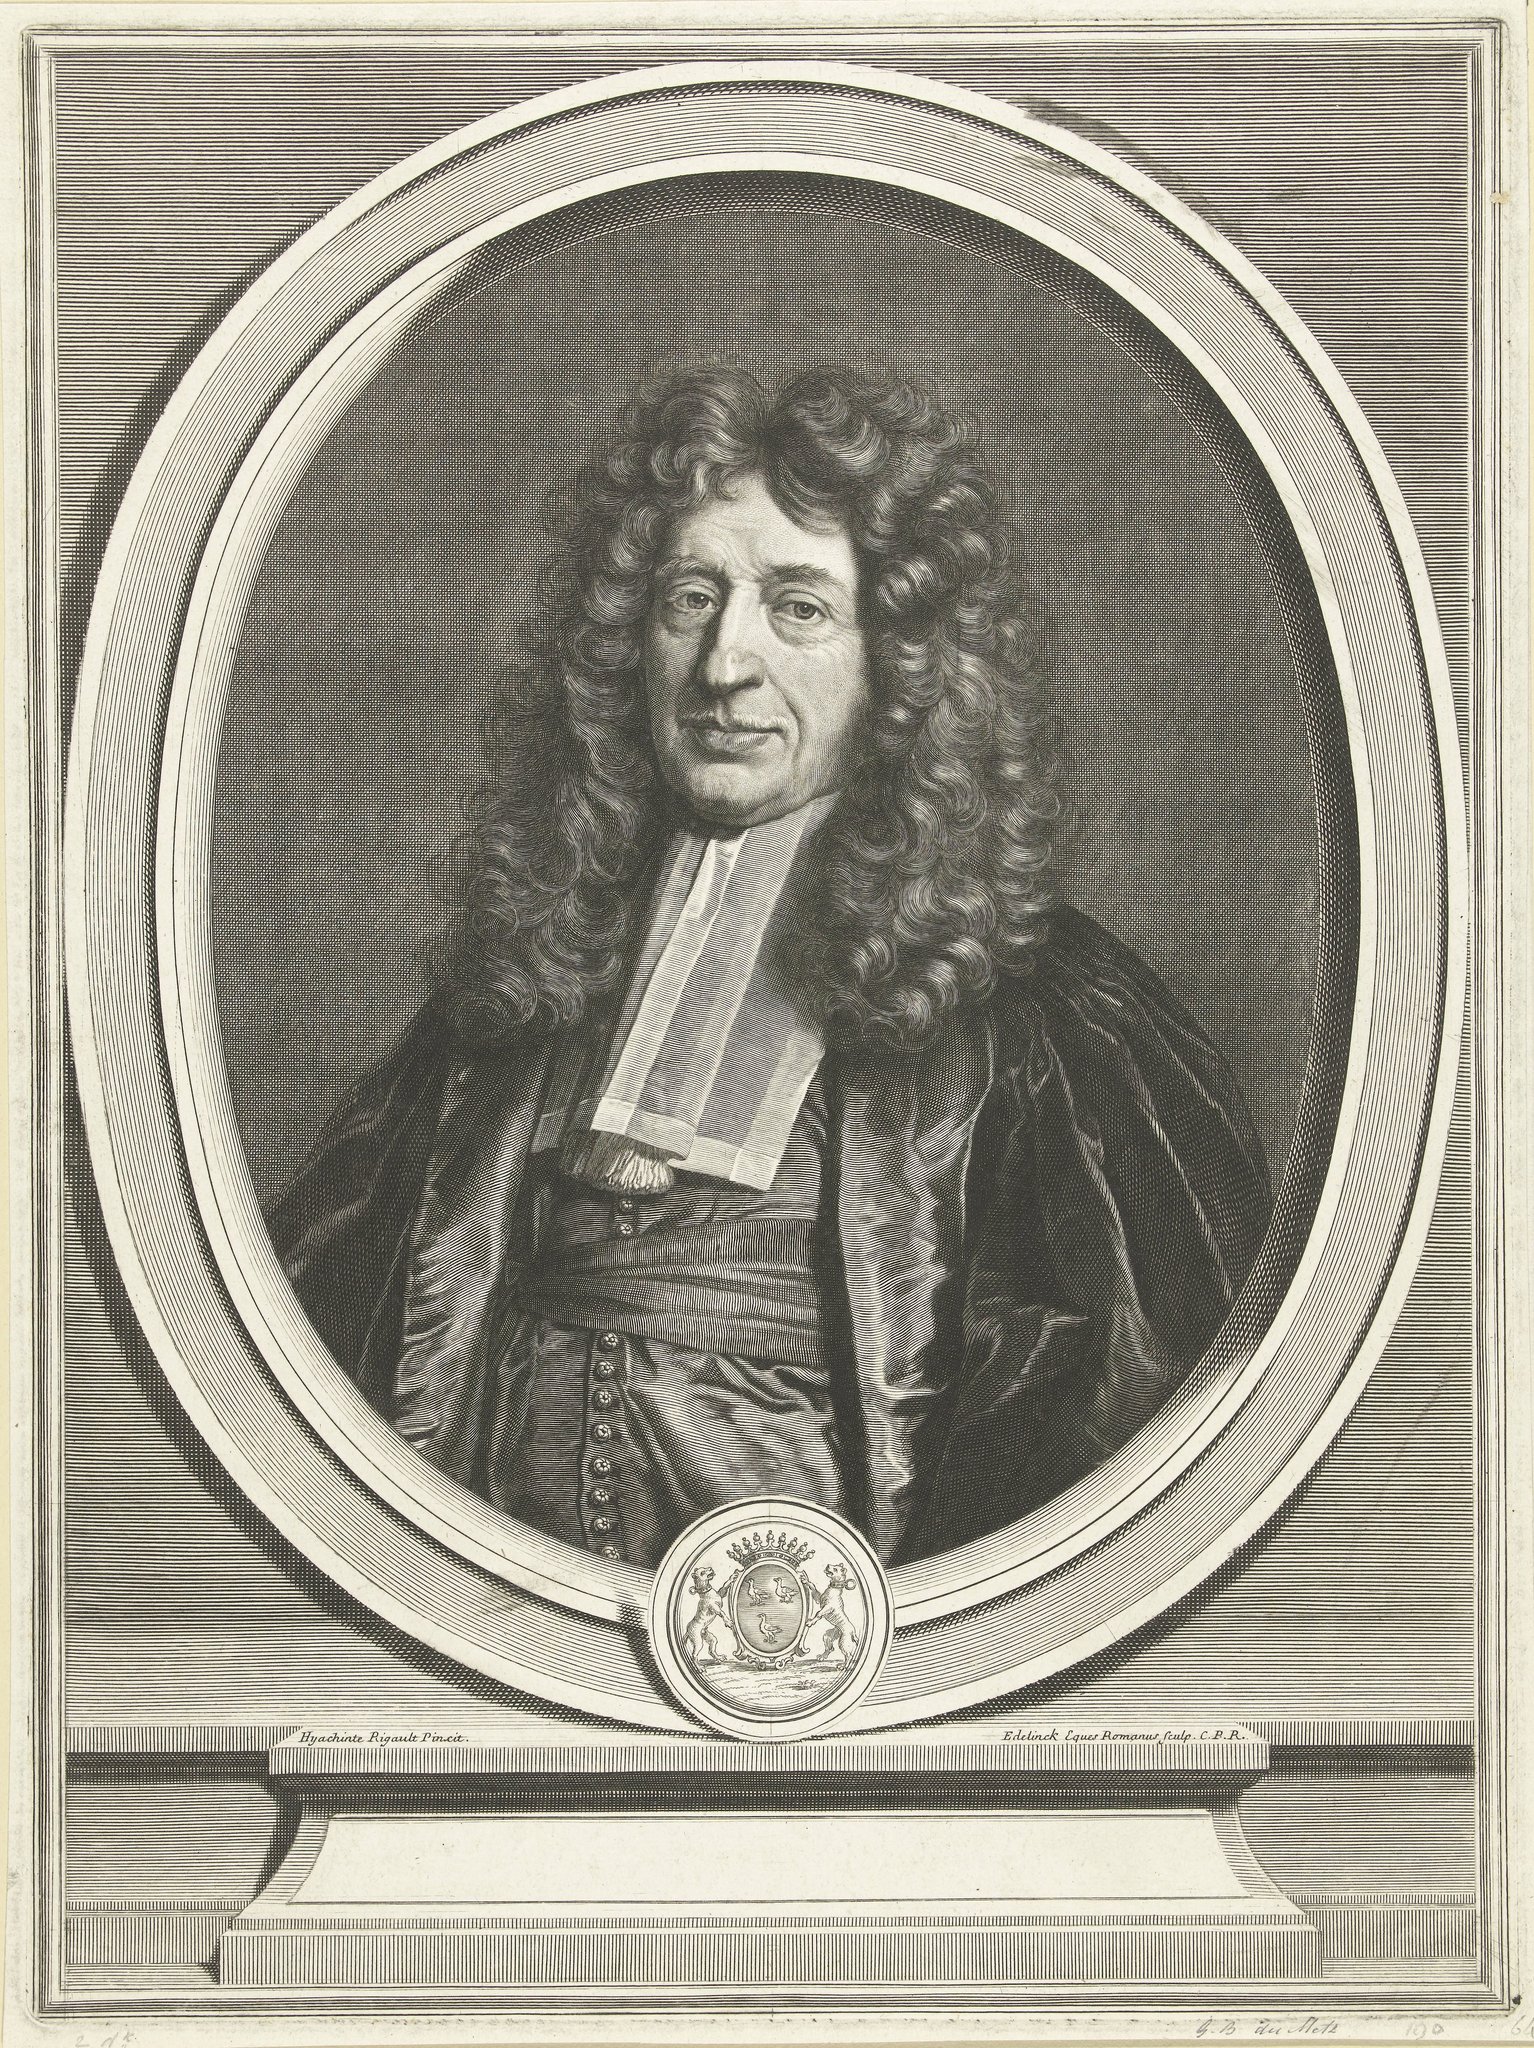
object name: print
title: Portret van Gédéon Berbier du Metz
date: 1698-1707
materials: paper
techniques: engraving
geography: france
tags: paris, gédéon berbier du metz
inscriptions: collector's mark: Lugt 240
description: Portret van Gédéon Berbier du Metz (1626-1709), hoofd van de Franse koninklijke rekenkamer, afgebeeld in ovale omlijsting met wapen.